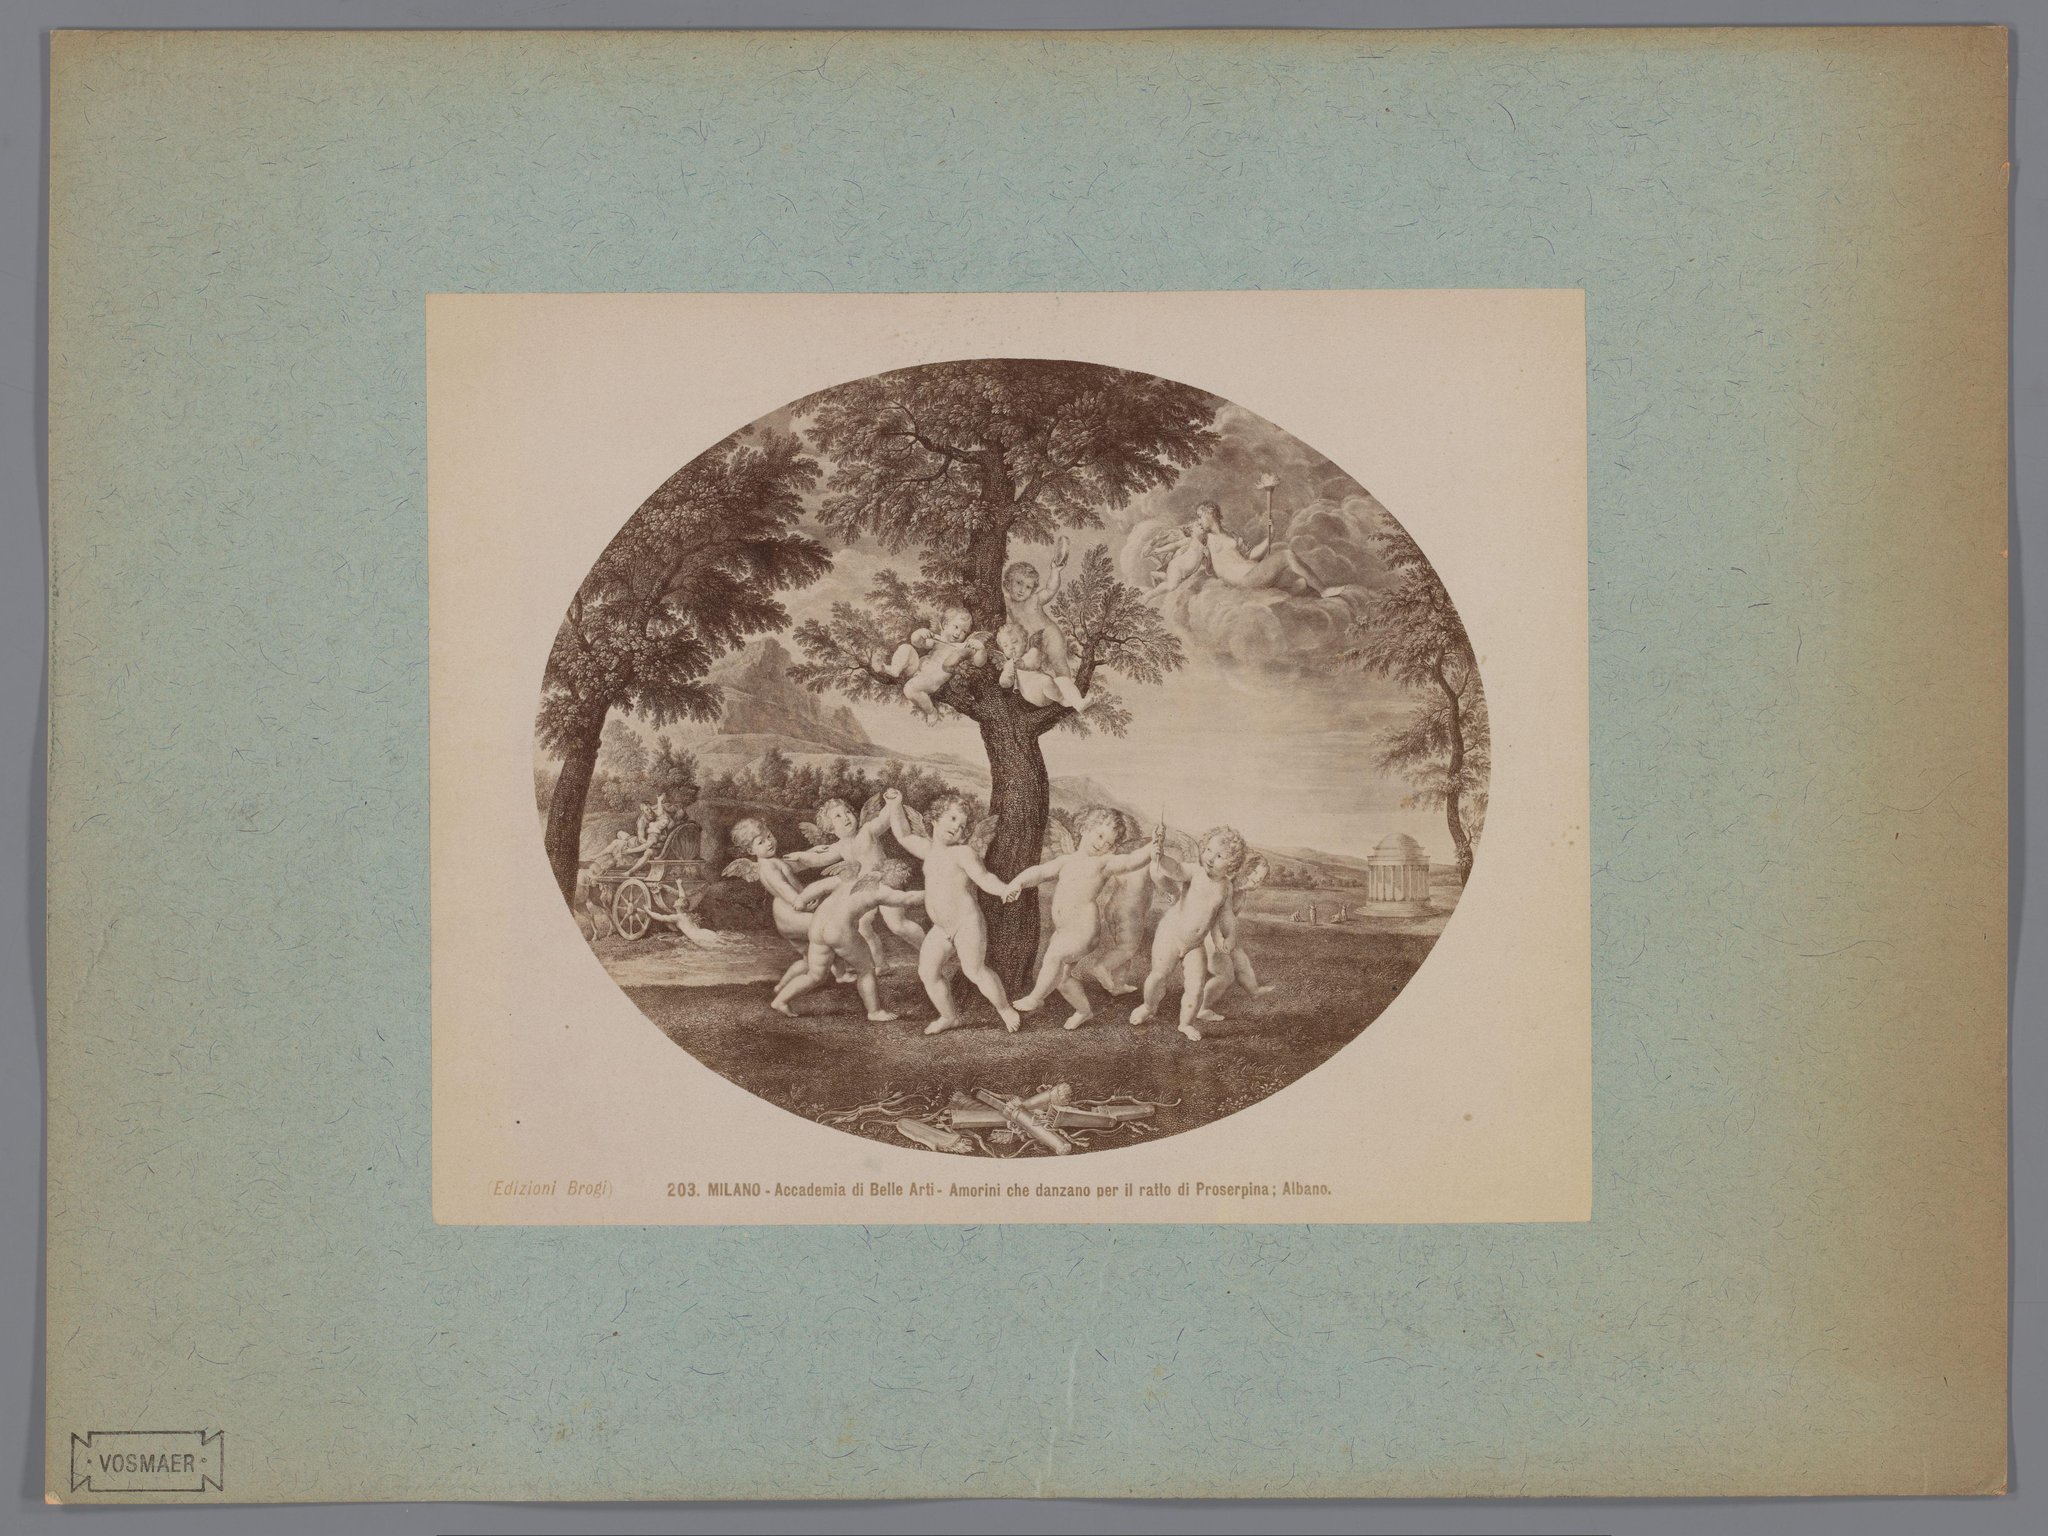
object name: photograph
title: Accademia di Belle Arti - Amorini che danzano per il ratto di Proserpina; Albano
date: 1856-1881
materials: cardboard, paper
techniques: albumen print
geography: florence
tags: picture, painting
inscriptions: number: ‘203.’, collector's mark: ‘VOSMAER’